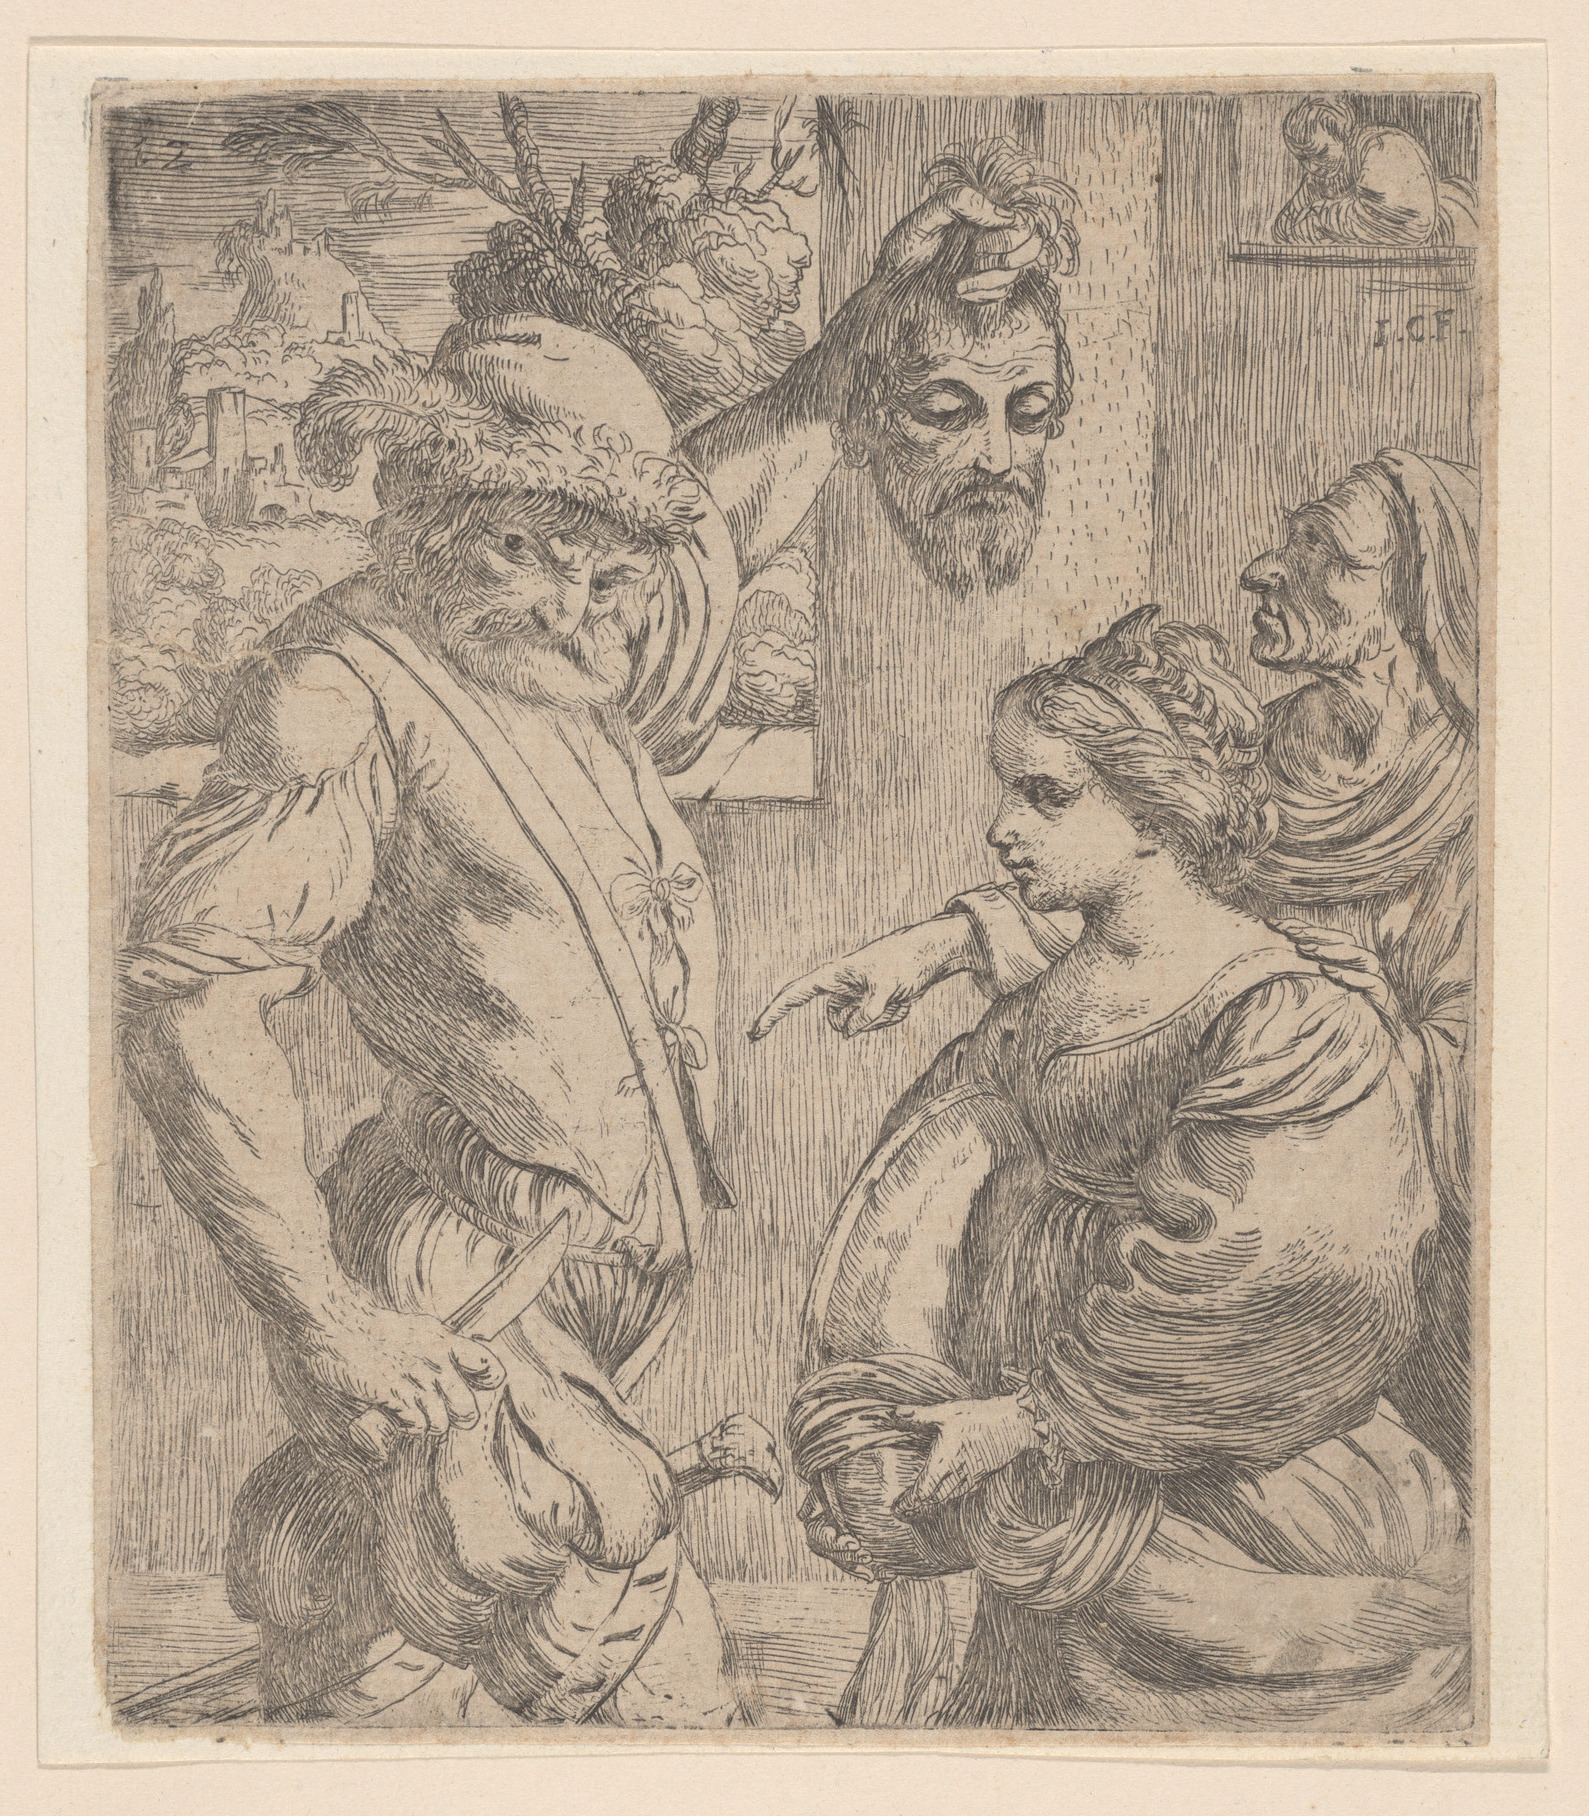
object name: print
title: The Beheading of Saint John the Baptist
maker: giuseppe caletti, called cremonese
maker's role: artist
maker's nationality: italian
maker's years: 1600-1660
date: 1620-1630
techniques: etching